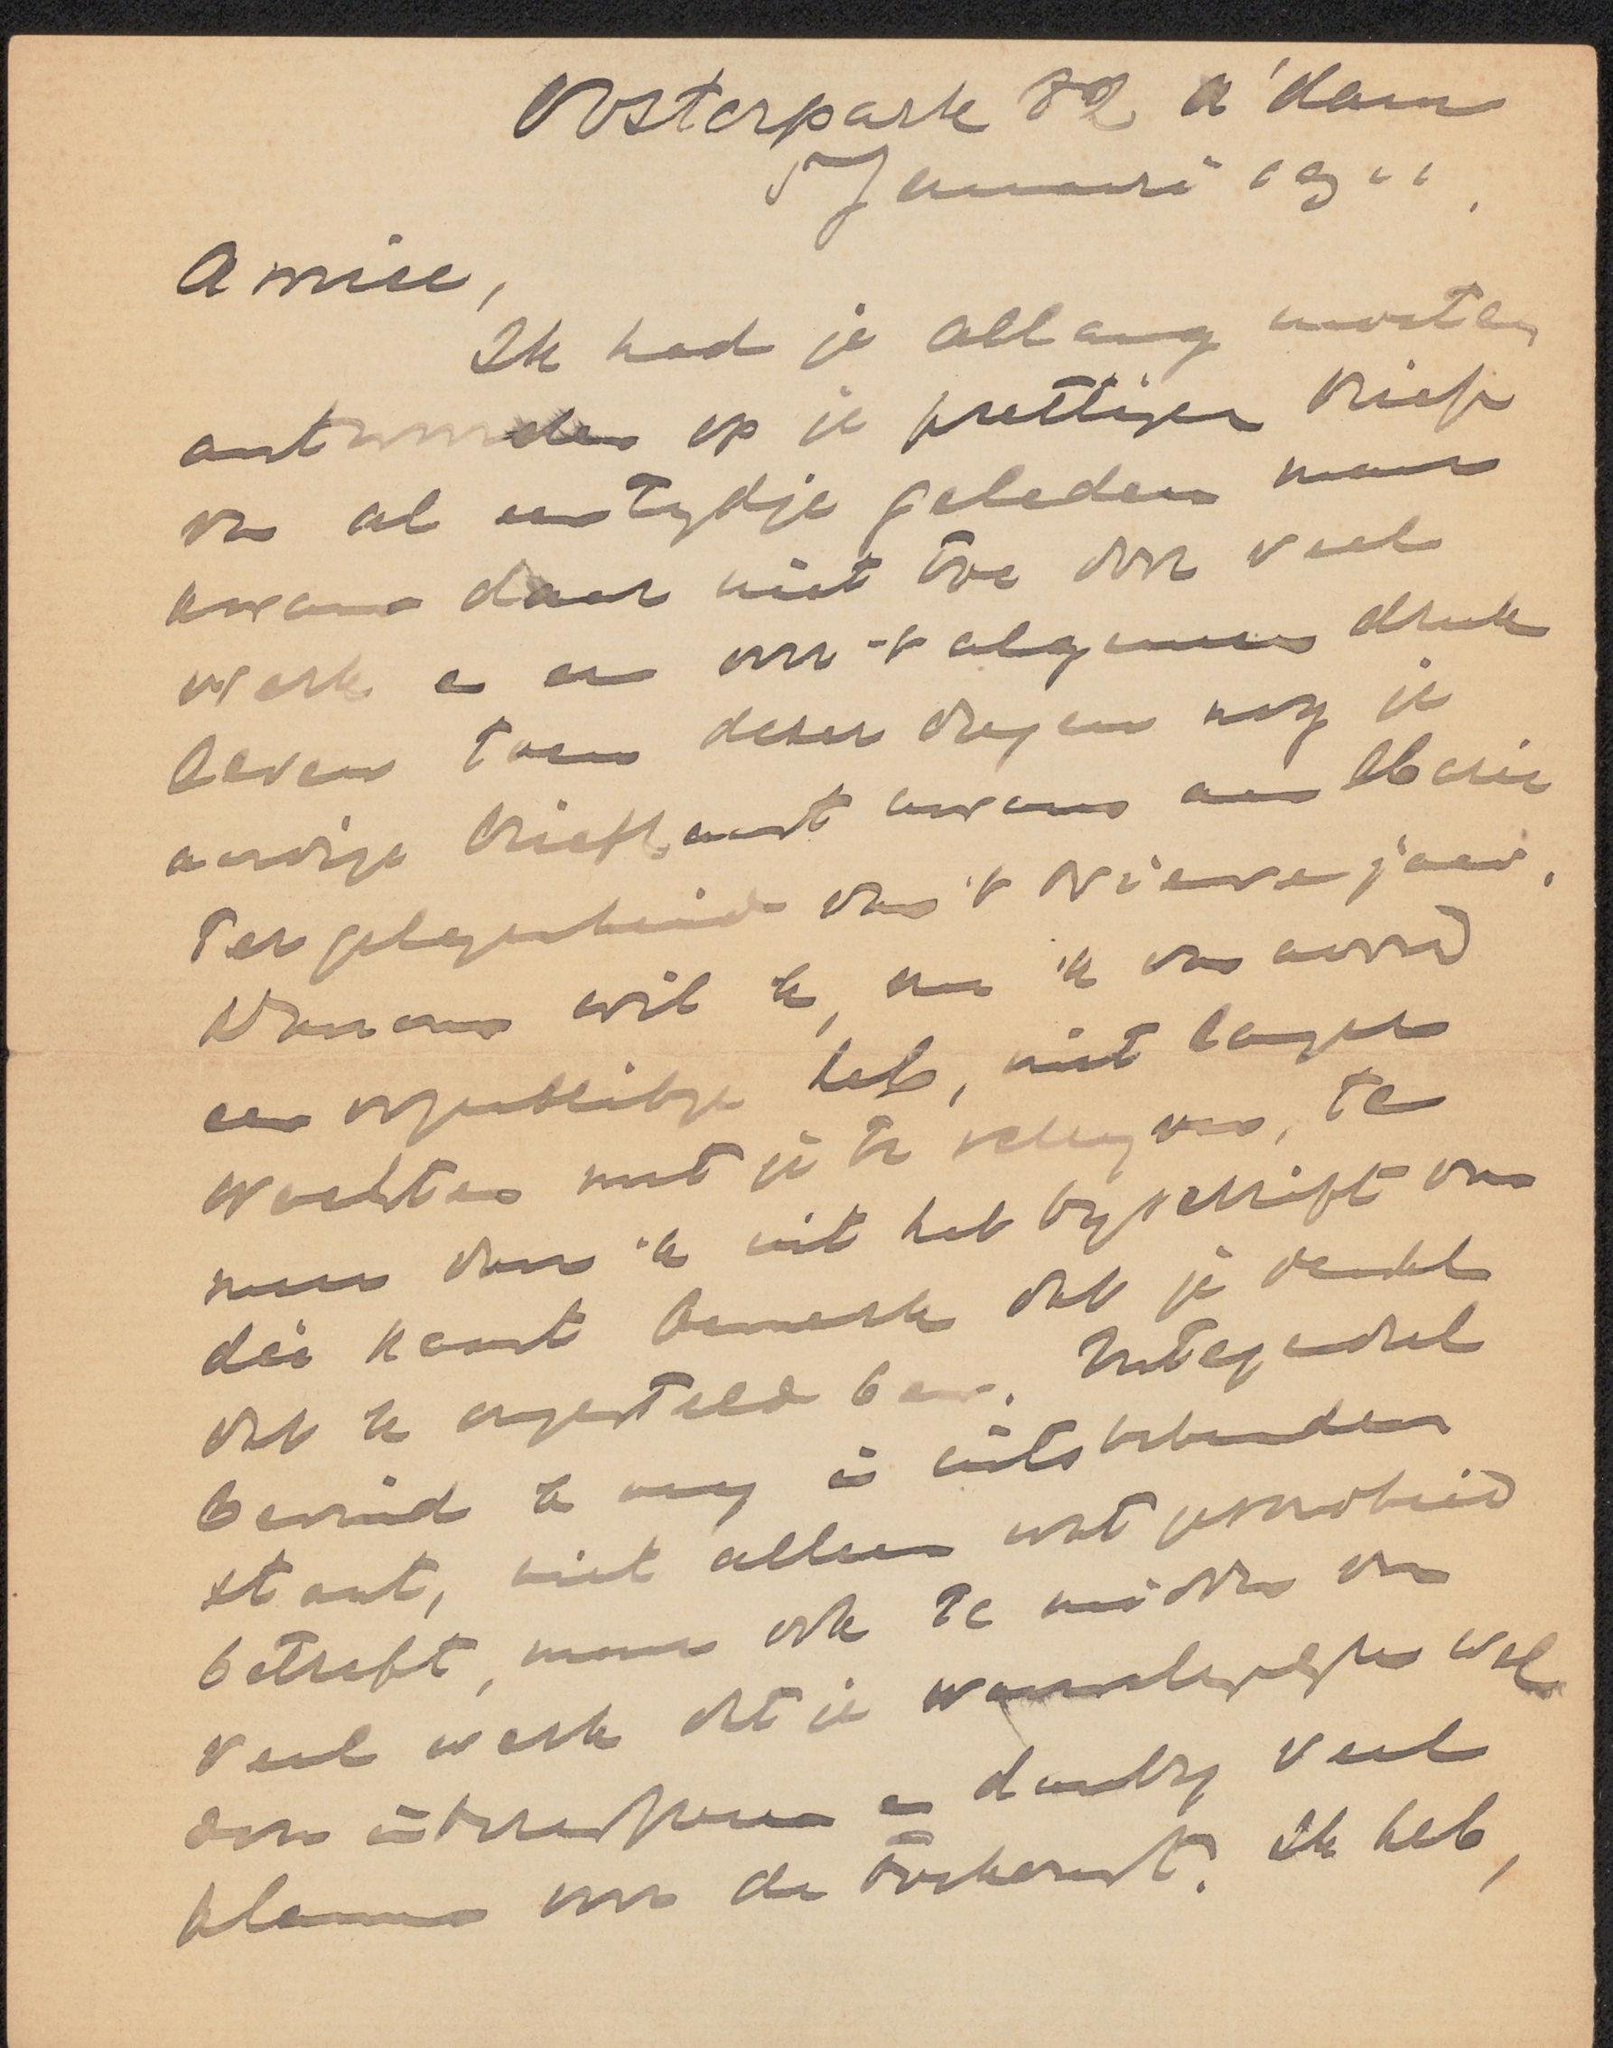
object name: letter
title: Brief aan Felicien Bobeldijk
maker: willem witsen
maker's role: draughtsman, painter, print maker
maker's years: 1860-1923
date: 1911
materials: ink, paper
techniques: pen, writing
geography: amsterdam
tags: felicien bobeldijk, amsterdam, the hague, painter, print maker, draughtsman, willem bastiaan tholen, the graphic arts, artist at work, in his workshop - bb - out of doors